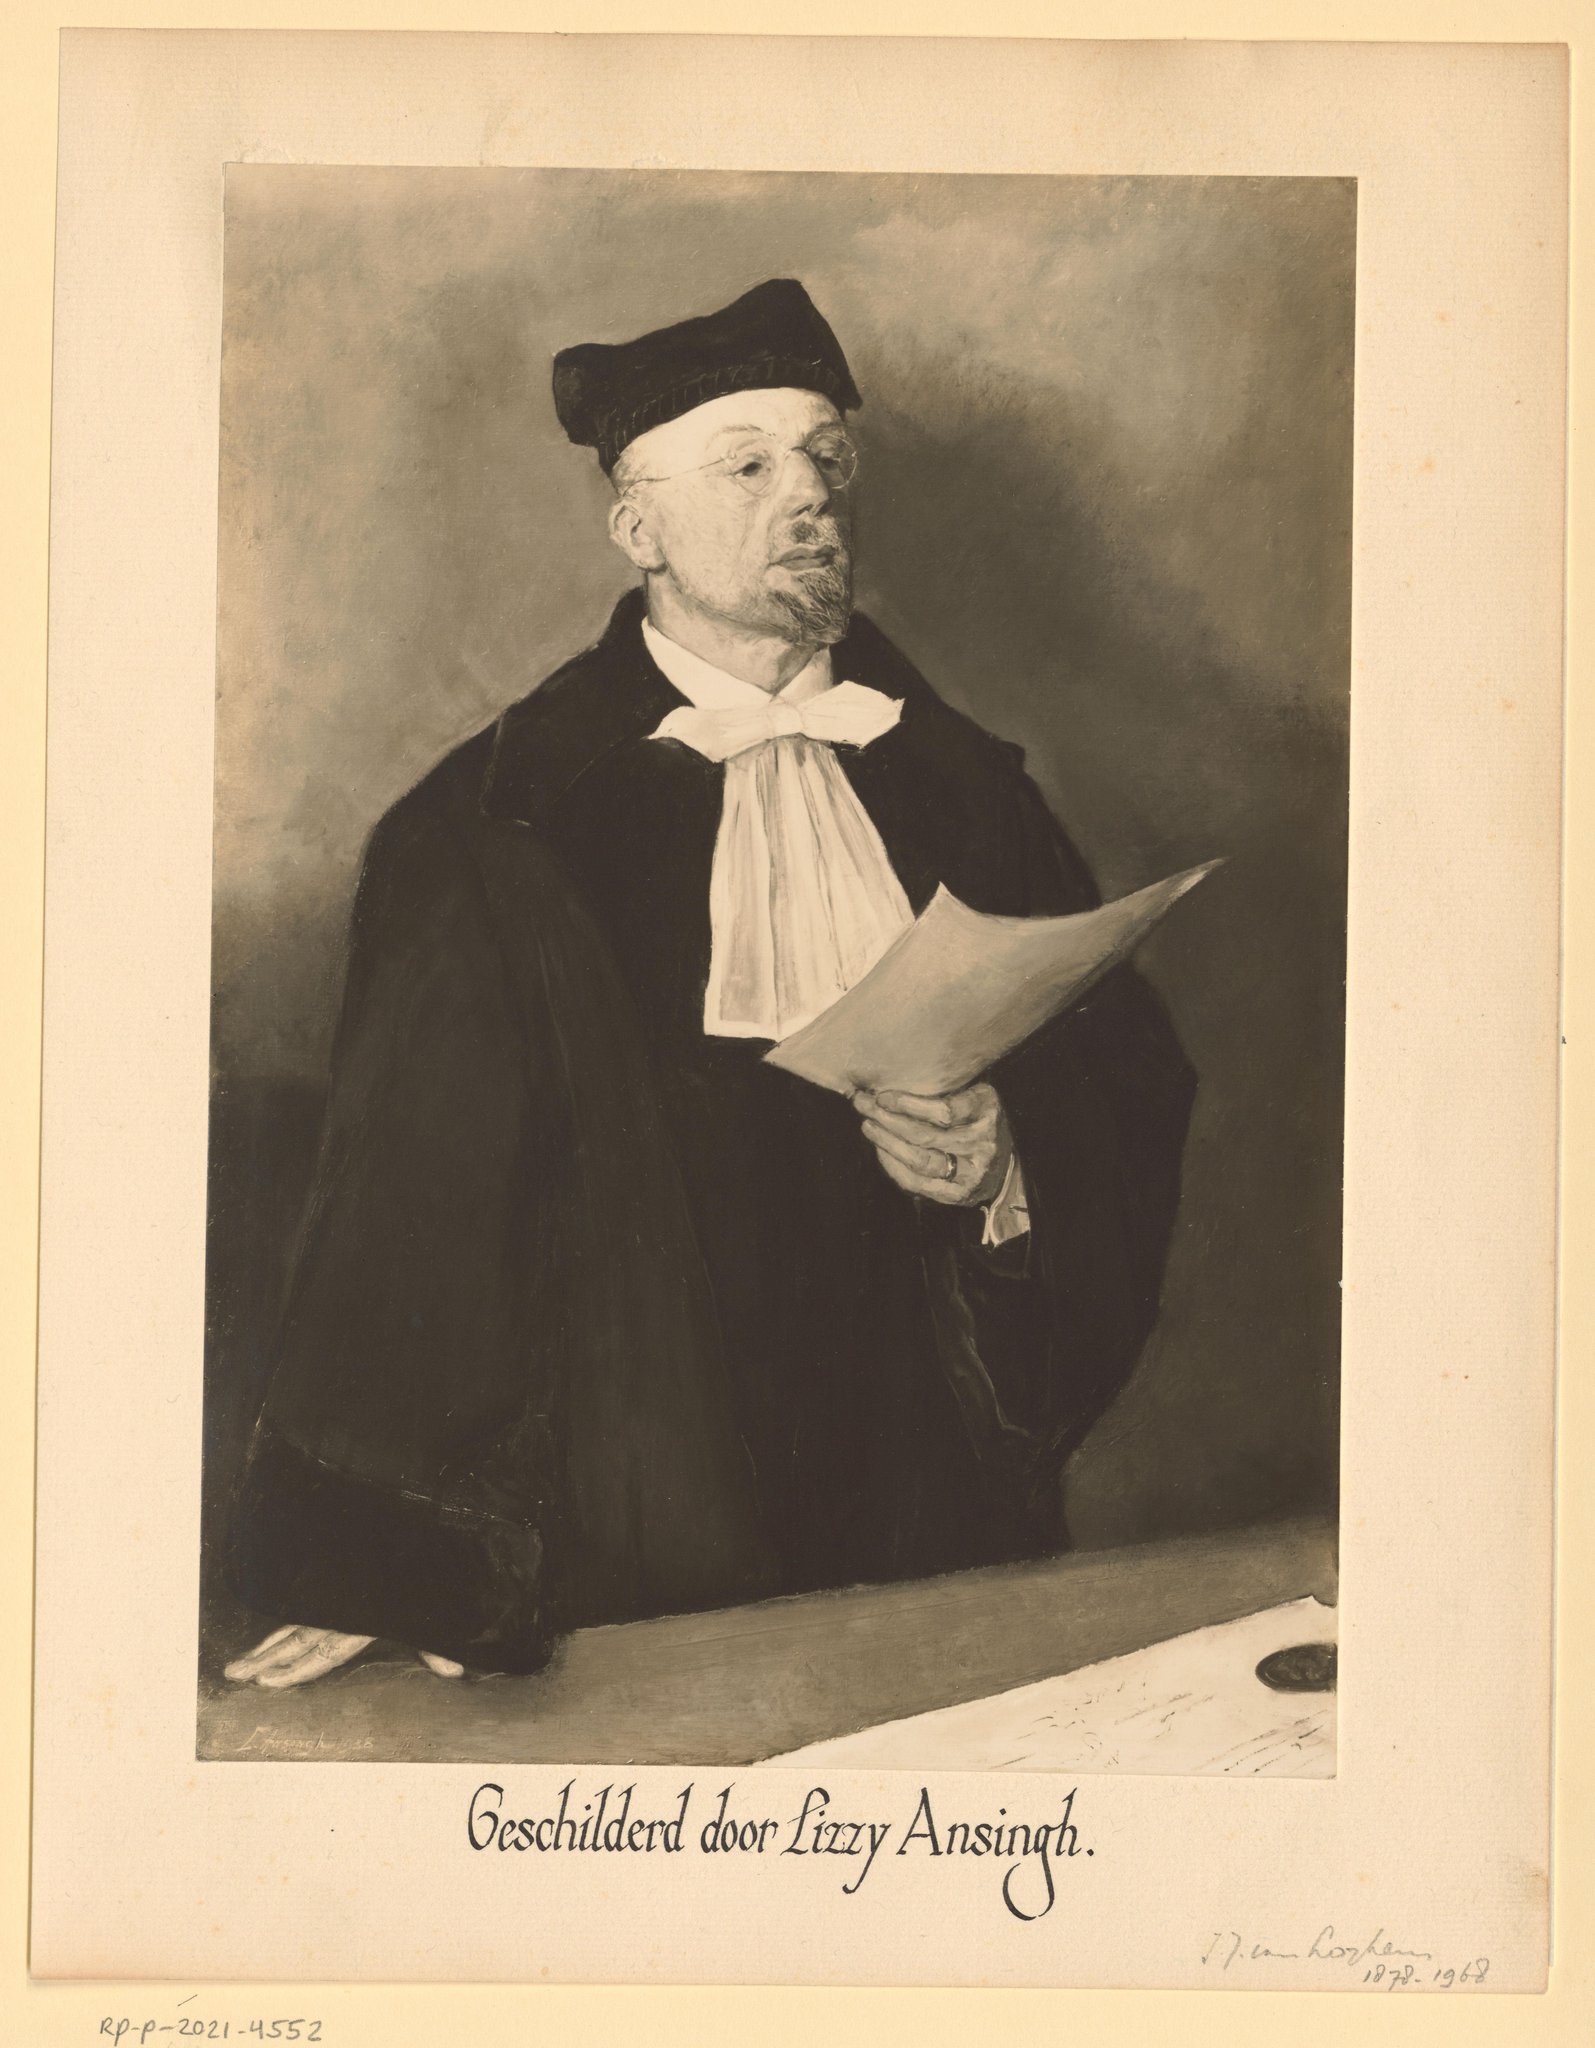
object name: photomechanical print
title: Portret van Johannes Jacobus van Loghem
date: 1938-1970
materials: paper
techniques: photoaquatint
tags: historical persons, professor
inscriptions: inscription: ‘Portret geschilderd in 1938/ Prof. Dr. Johannes Jacobus van Loghem/ 10 April 1878-31 Oktober 1968/ te Amsterdam./ in bezit van de familie [...] Asd (?). 1968’, inscription: ‘Geschilderd door Lizzy Ansingh’